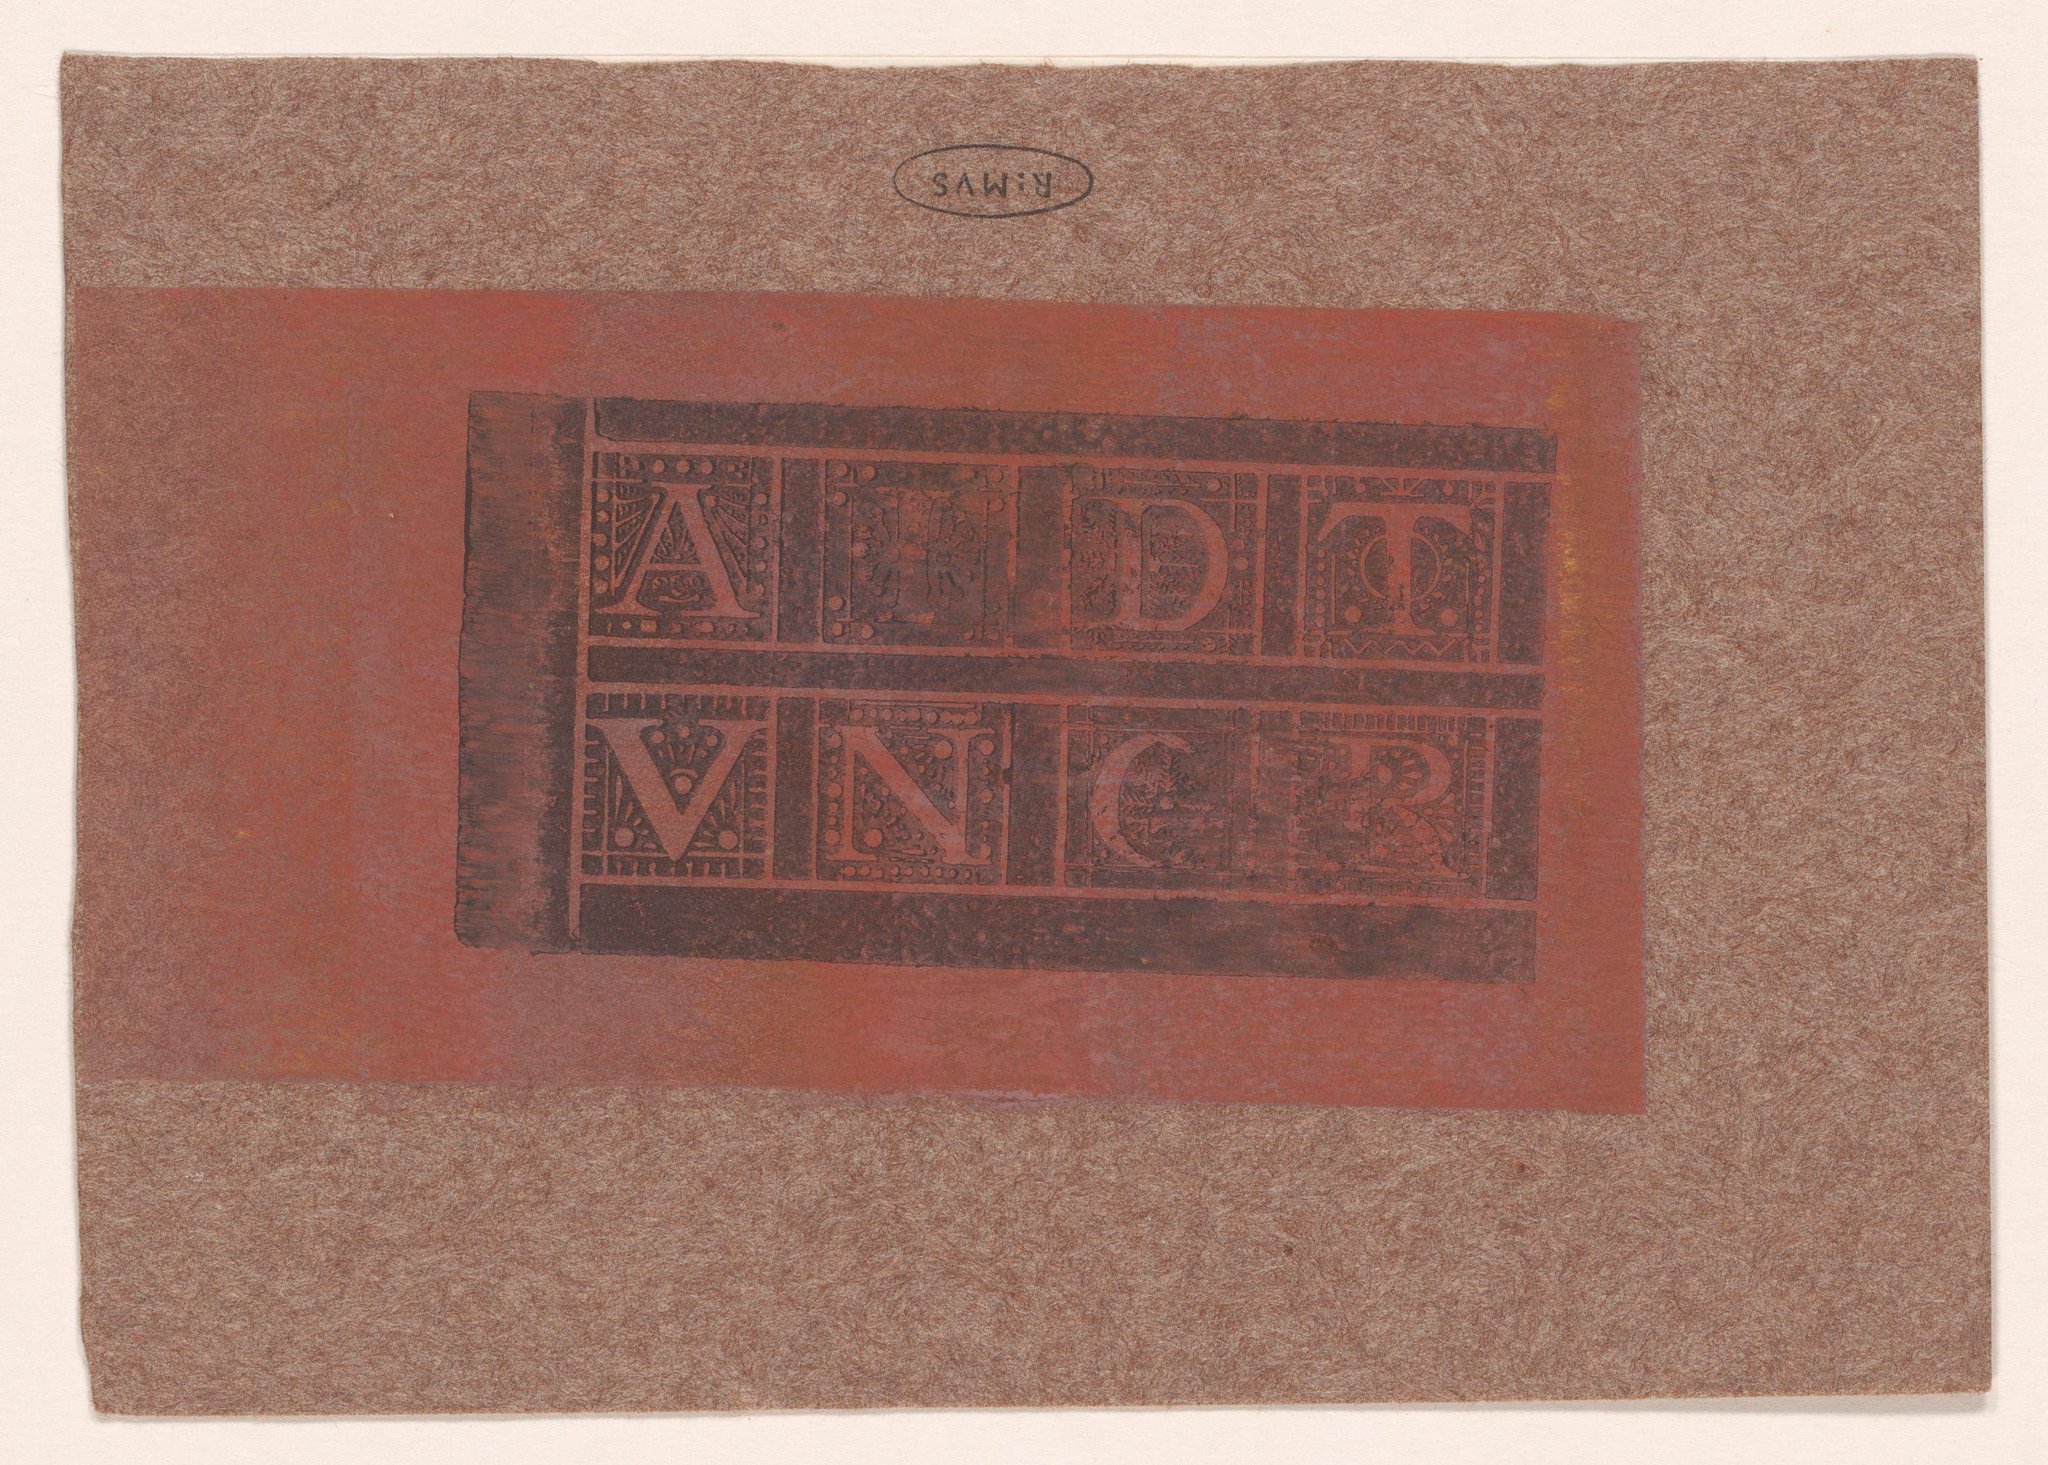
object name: boekillustratie ontwerp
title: Letters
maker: bernard willem wierink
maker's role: draughtsman, print maker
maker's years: 1856-1939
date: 1910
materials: paper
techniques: relief print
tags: letters, alphabet, script, fable of reynard the fox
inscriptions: collector's mark: Lugt 2228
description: Waarschijnlijk ontwerp voor: Streuvels, Stijn (Frank Lateur). Reinaert de Vos naar verschillende uitgaven van het middeleeuwsche epos. Amsterdam: L.J. Veen, 1910. Deze prent is vermoedelijk een plaatsnede, ook al wordt in de literatuur veelal gesproken over een houtsnede. Voor zover Wierink zijn prenten in hoogdruk zelf nader heeft omschreven, heeft hij altijd de term 'plaatsnede' gebruikt.